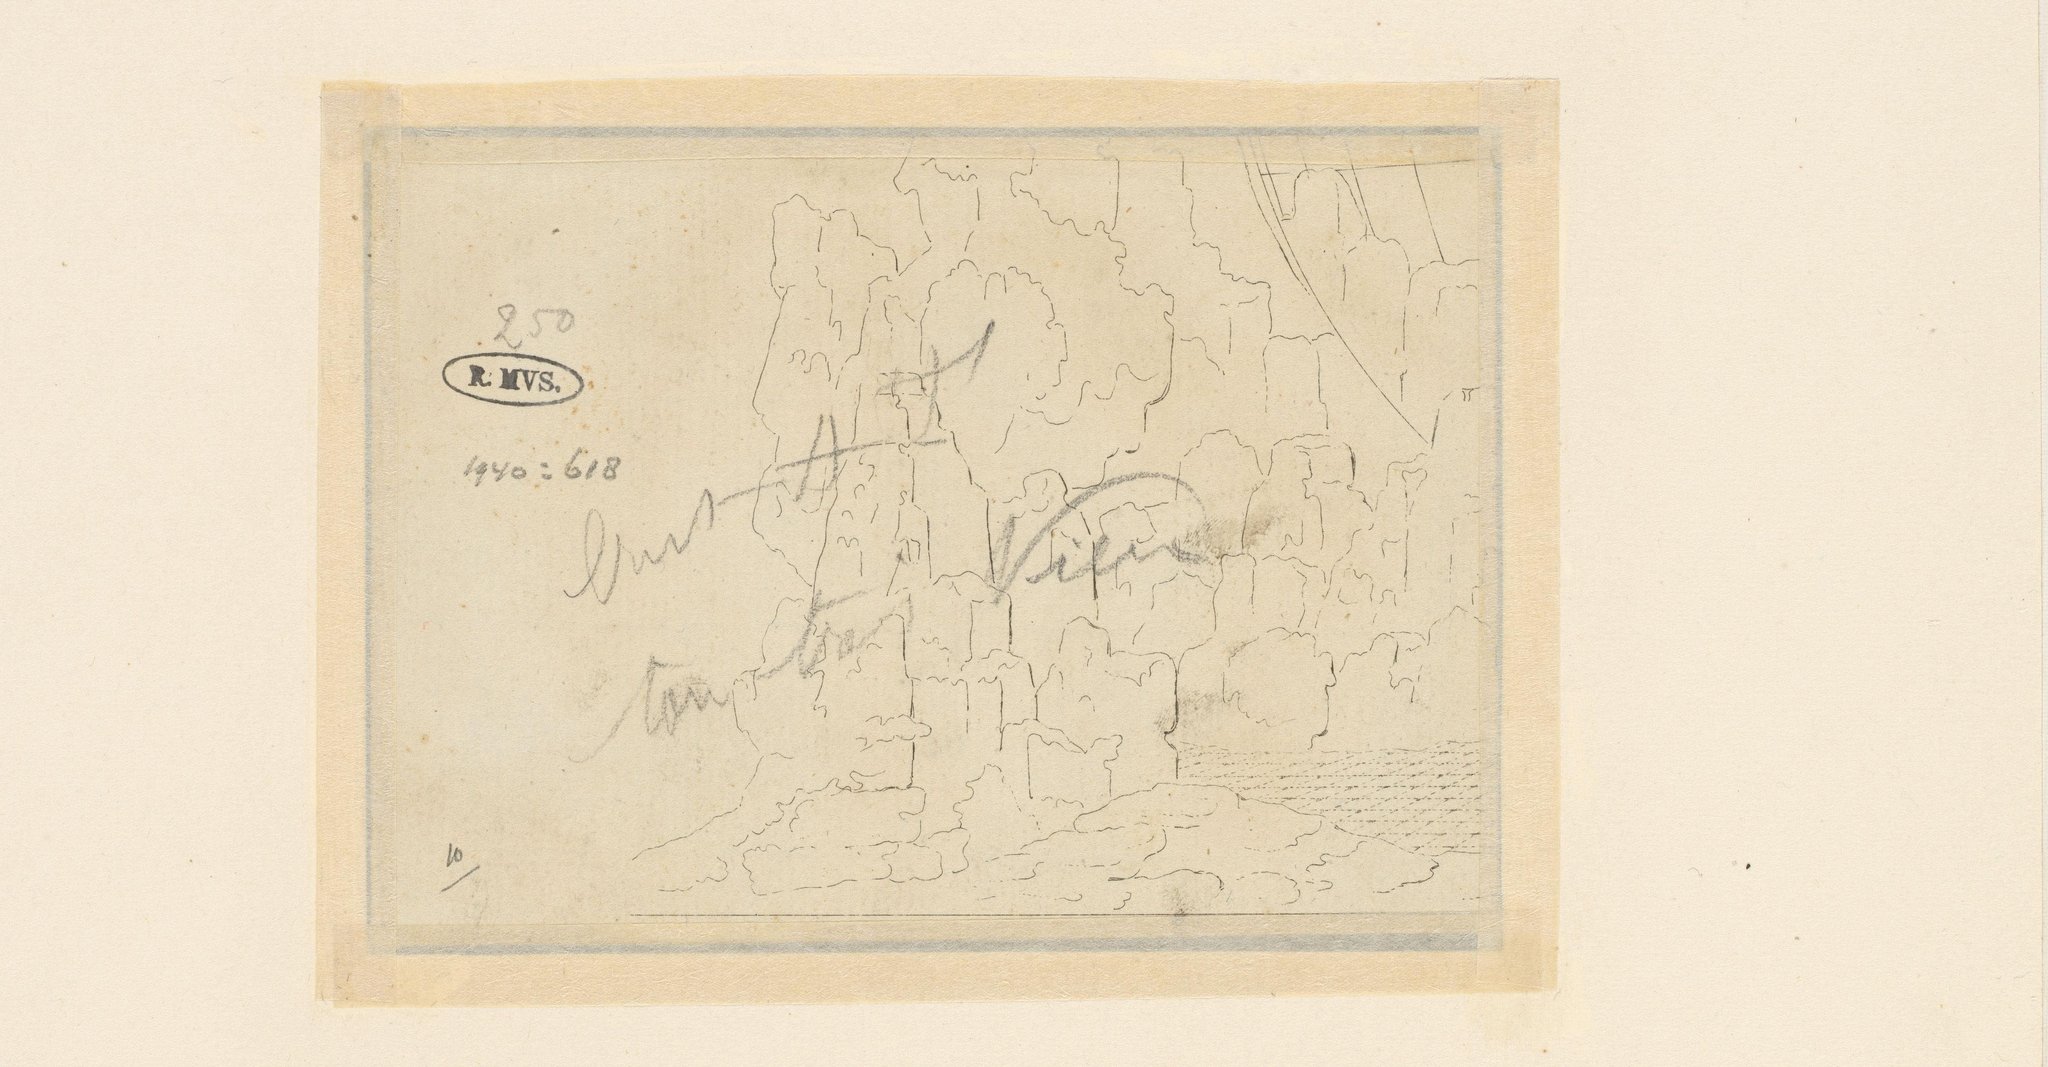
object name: drawing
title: Schets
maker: alphonse jean baptiste vien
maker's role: draughtsman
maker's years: 1814-1874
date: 1800-1900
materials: ink, paper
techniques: pen